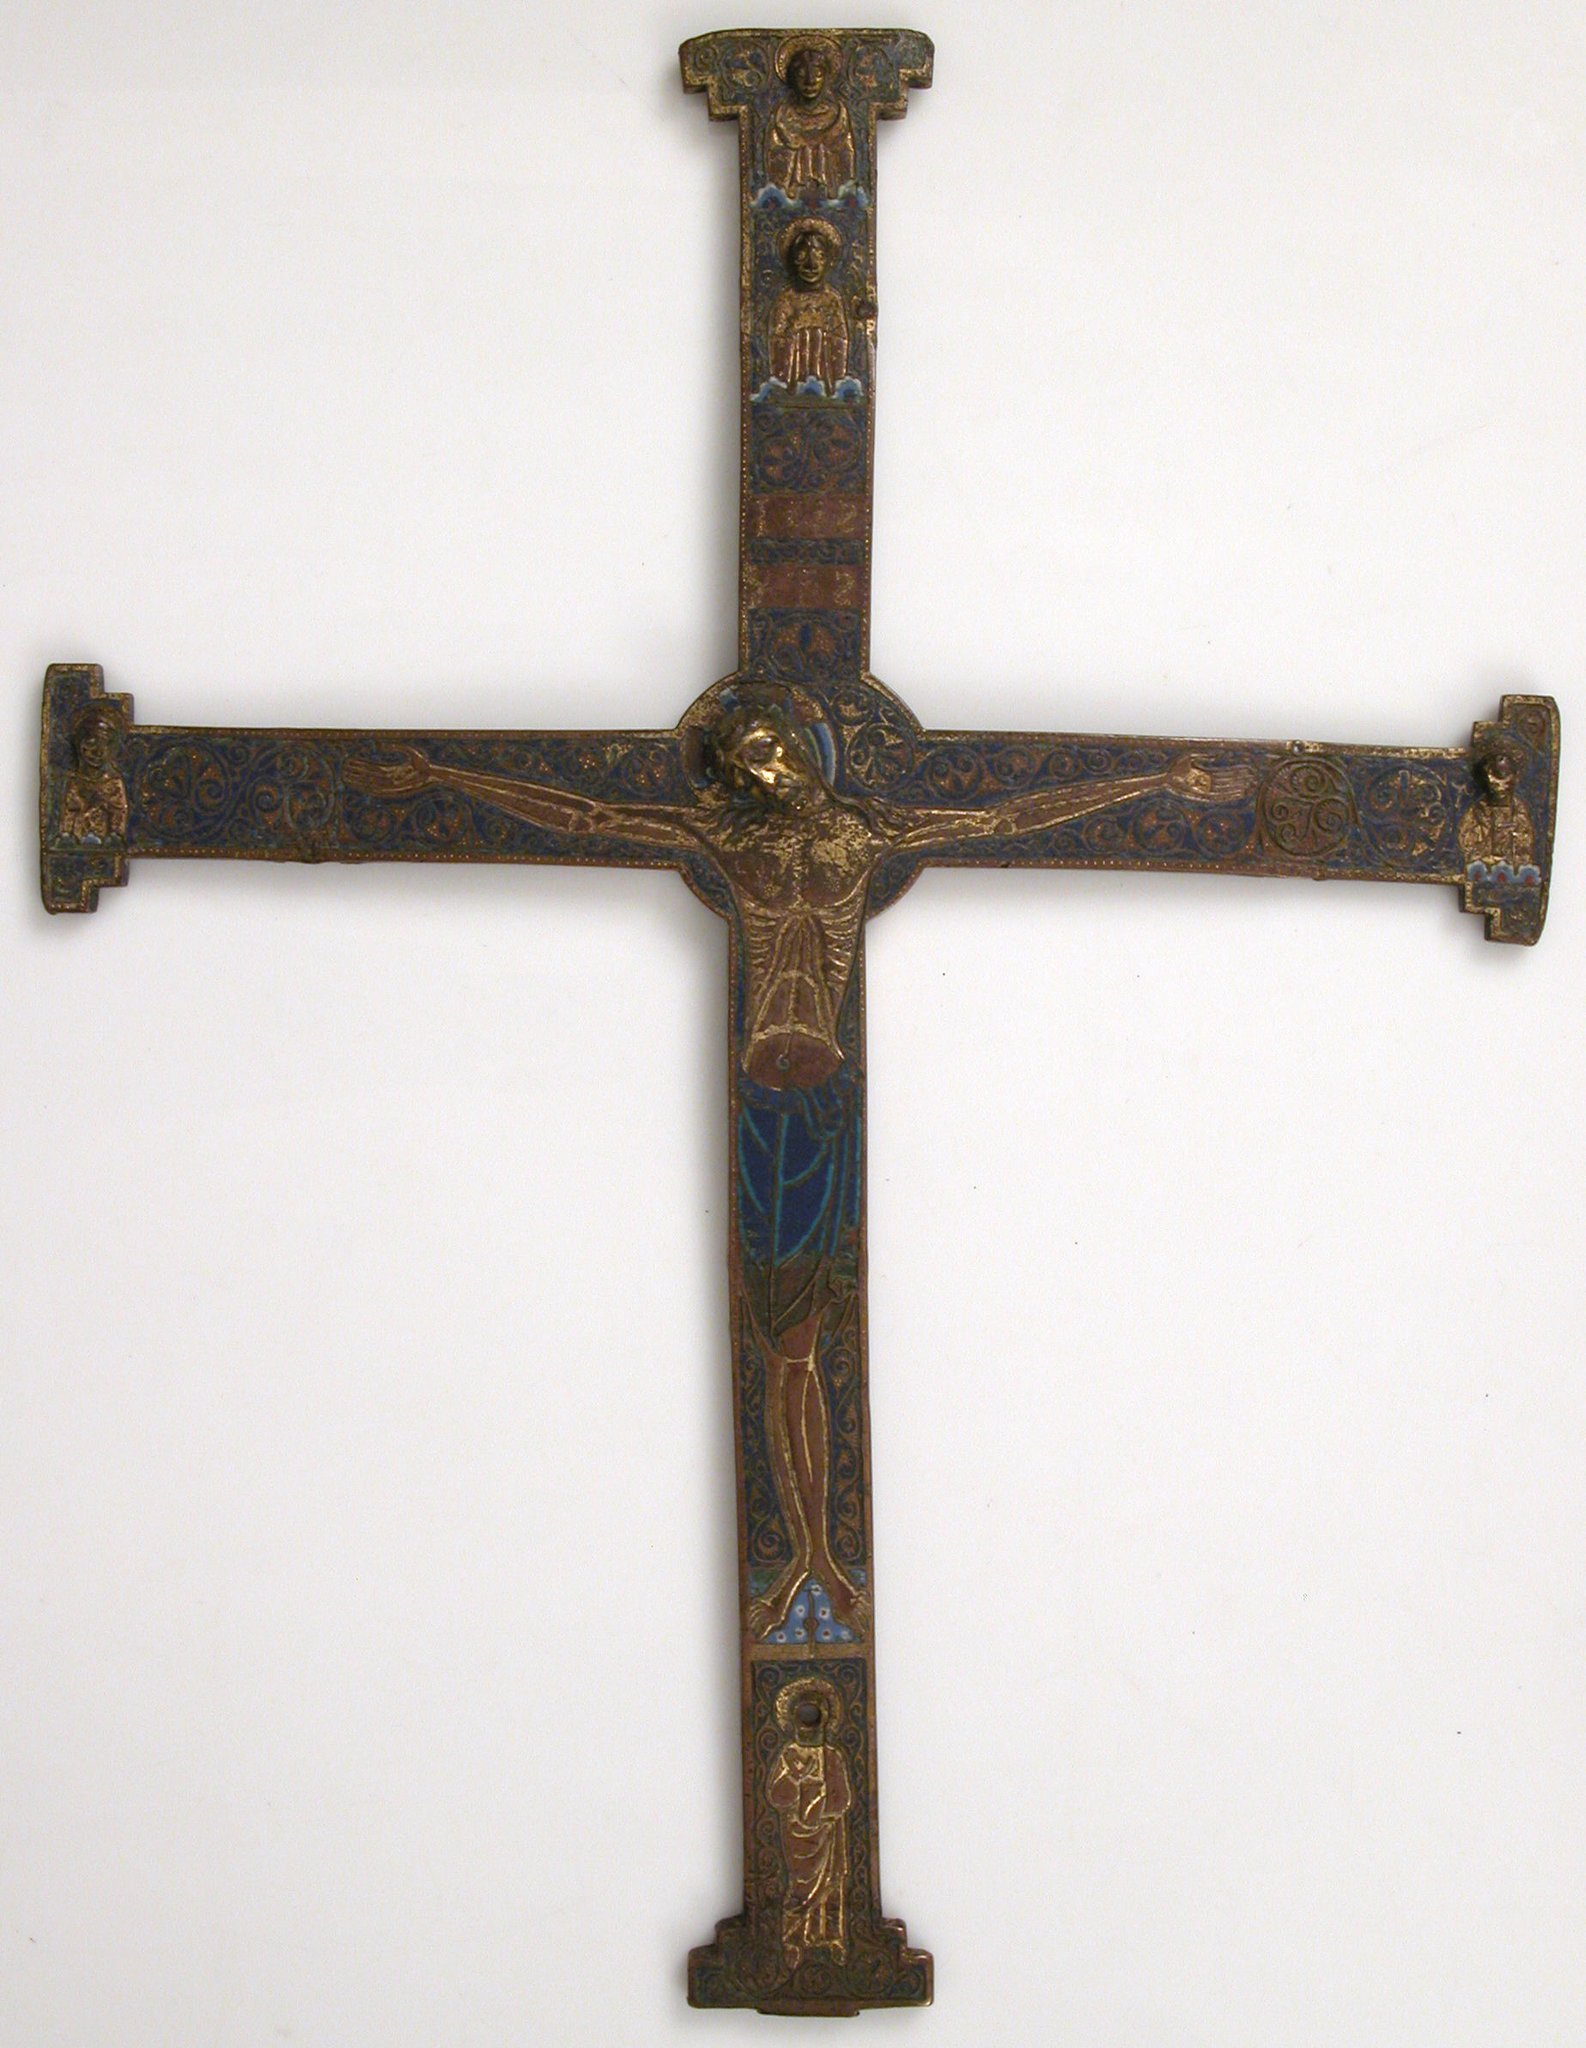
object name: cross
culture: french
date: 1180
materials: copper, enamel, gilt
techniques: appliqué, enamel, chasing, engraving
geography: france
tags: human figures,christ